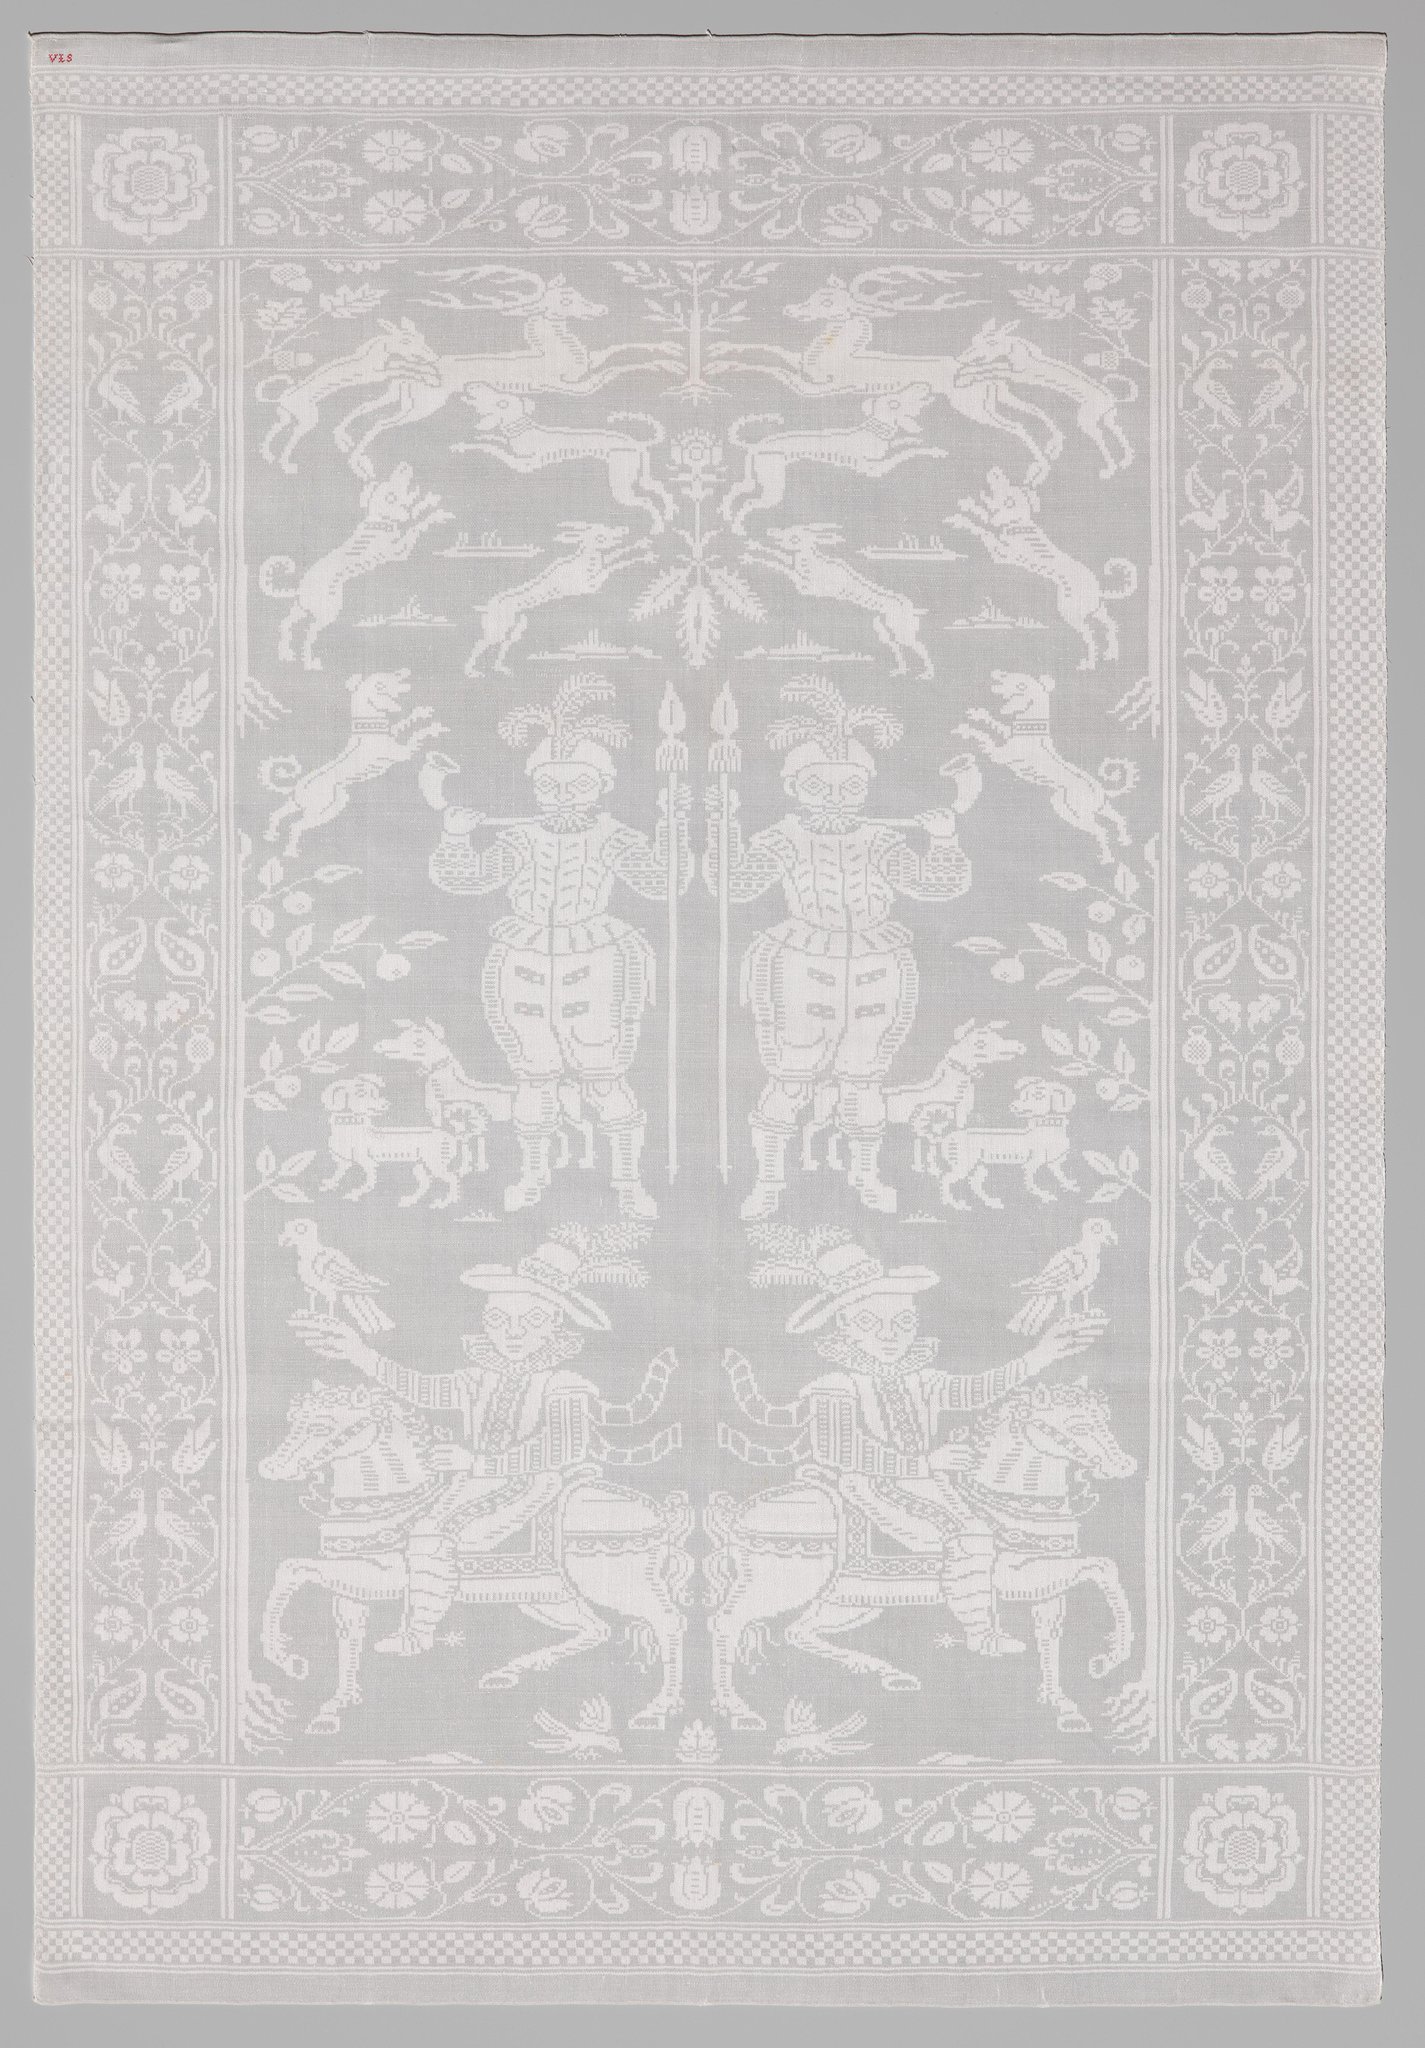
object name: napkin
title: Servet met valken- en hertenjacht.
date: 1625-1650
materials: linen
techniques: damask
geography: netherlands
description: Wit linnen damasten servet met valken- en hertenjacht.